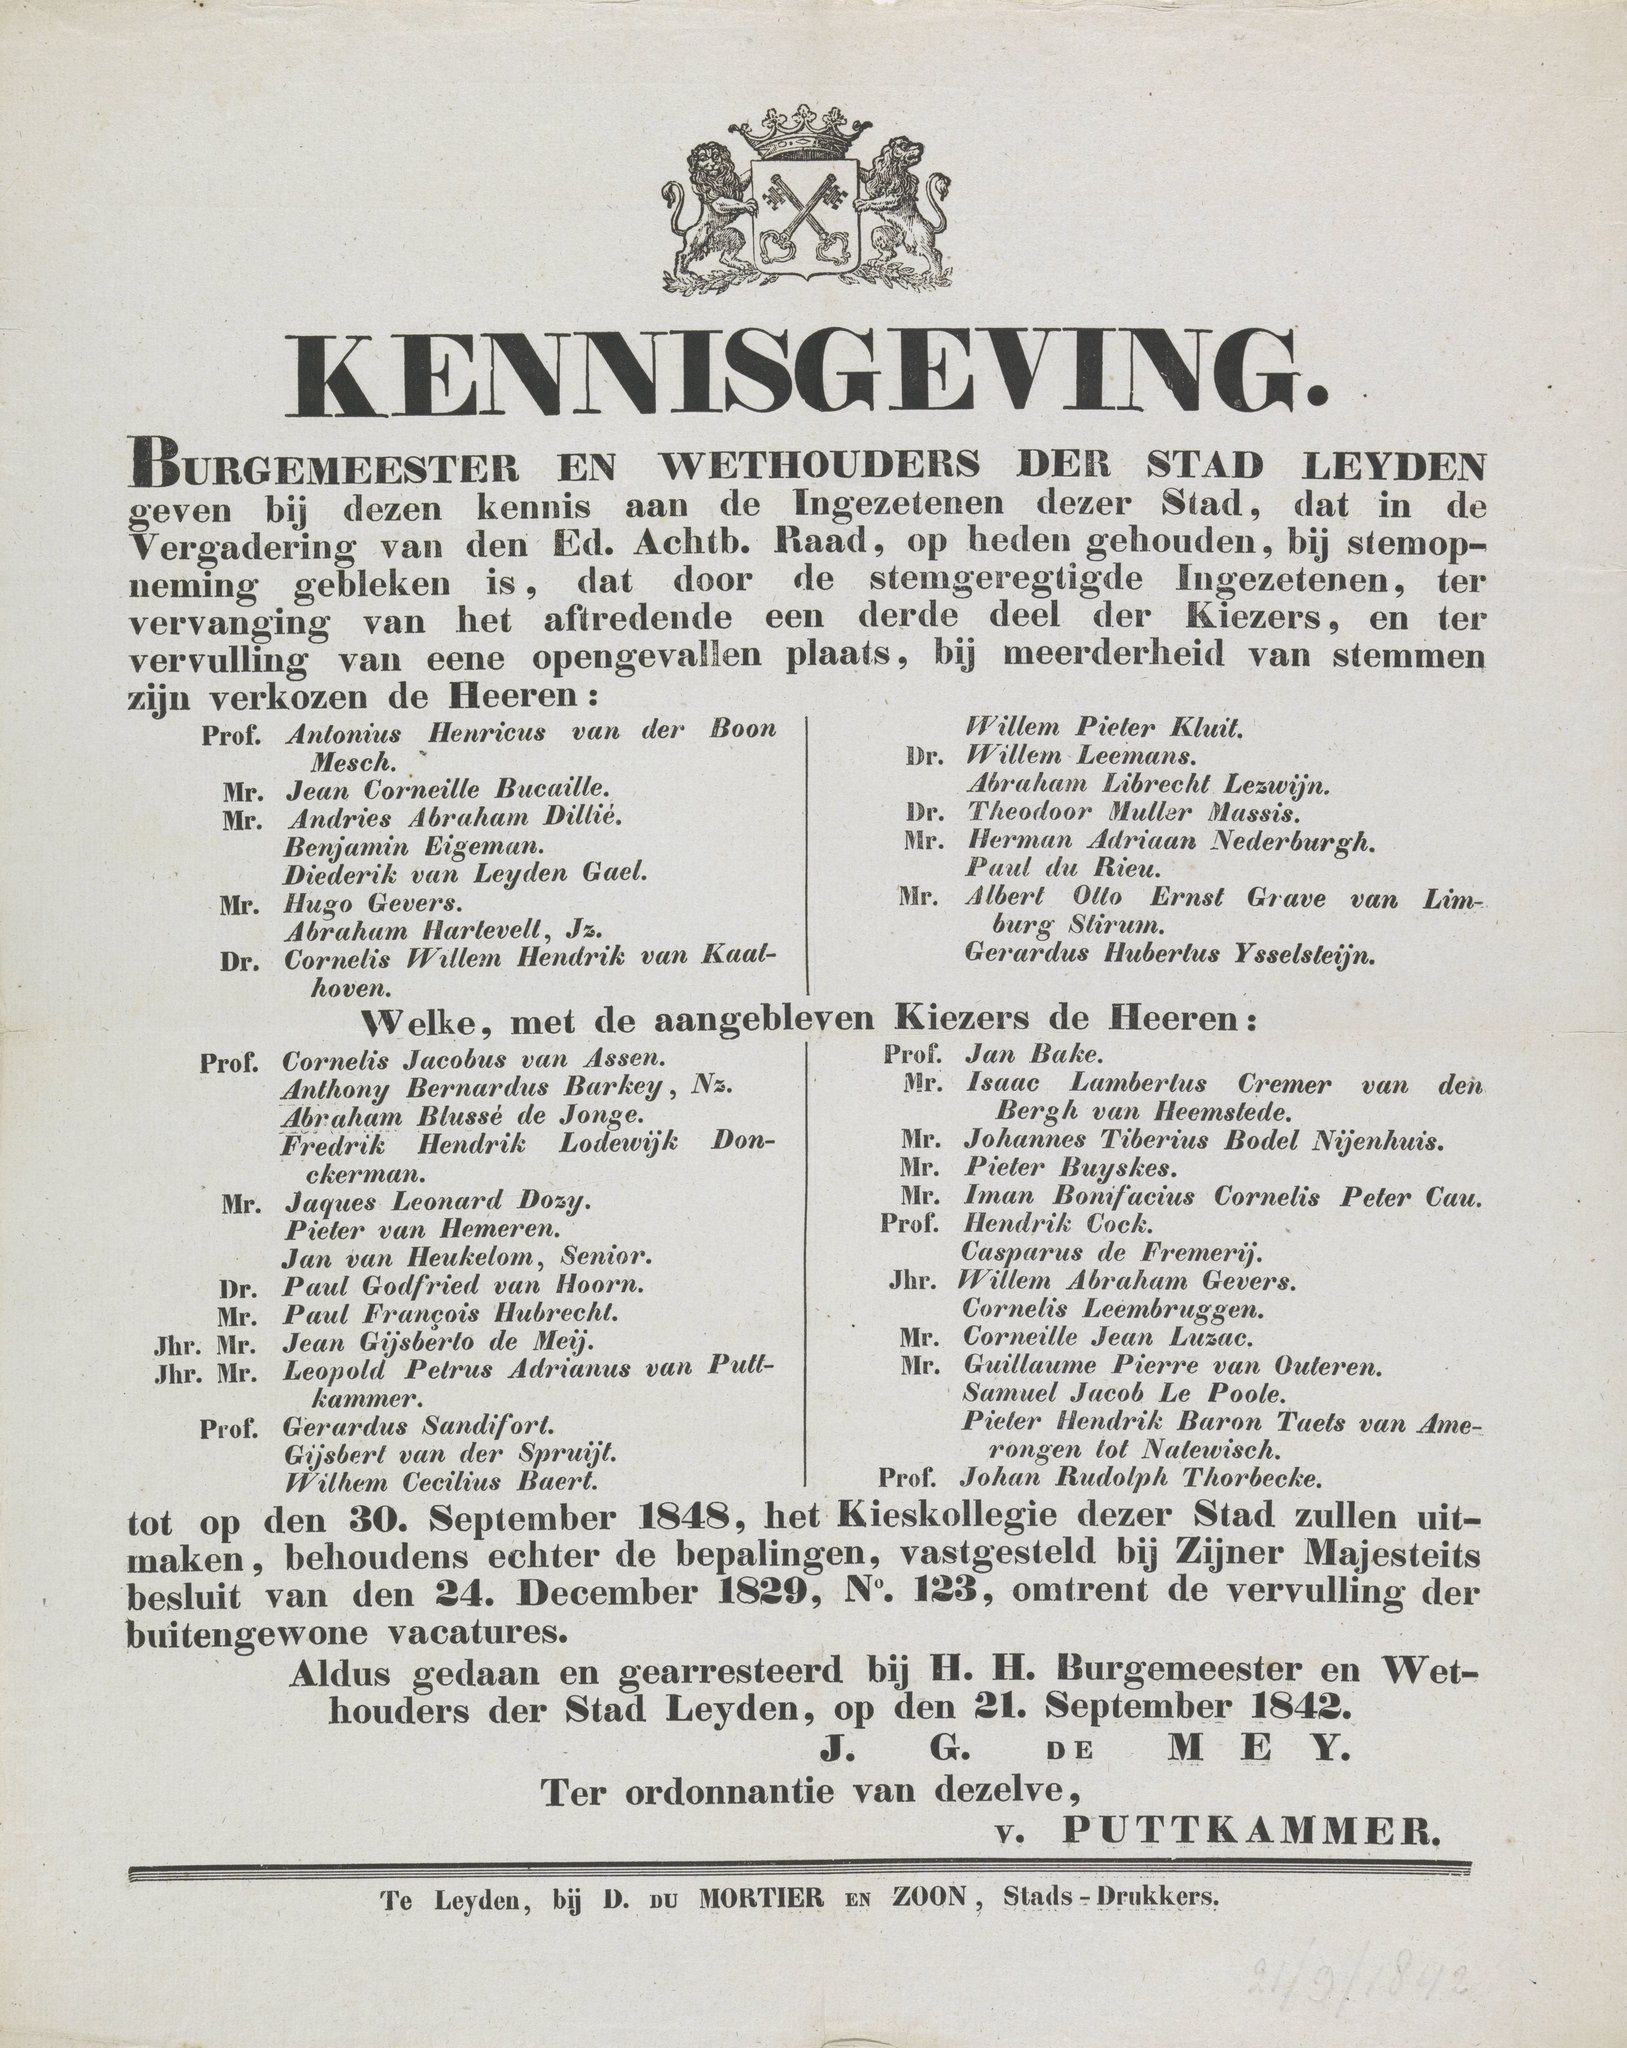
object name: text sheet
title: Kennisgeving wie verkozen zijn in de Raad van Leiden, 1842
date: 1809-1842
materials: paper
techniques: letterpress printing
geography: leiden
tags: leiden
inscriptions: collector's mark: Lugt 2228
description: Gemeentelijke kennisgeving van de uitslag van de verkiezingen voor de raad van de stad Leiden, 21 september 1842. Bovenaan een vignet met het Leidse stadswapen.